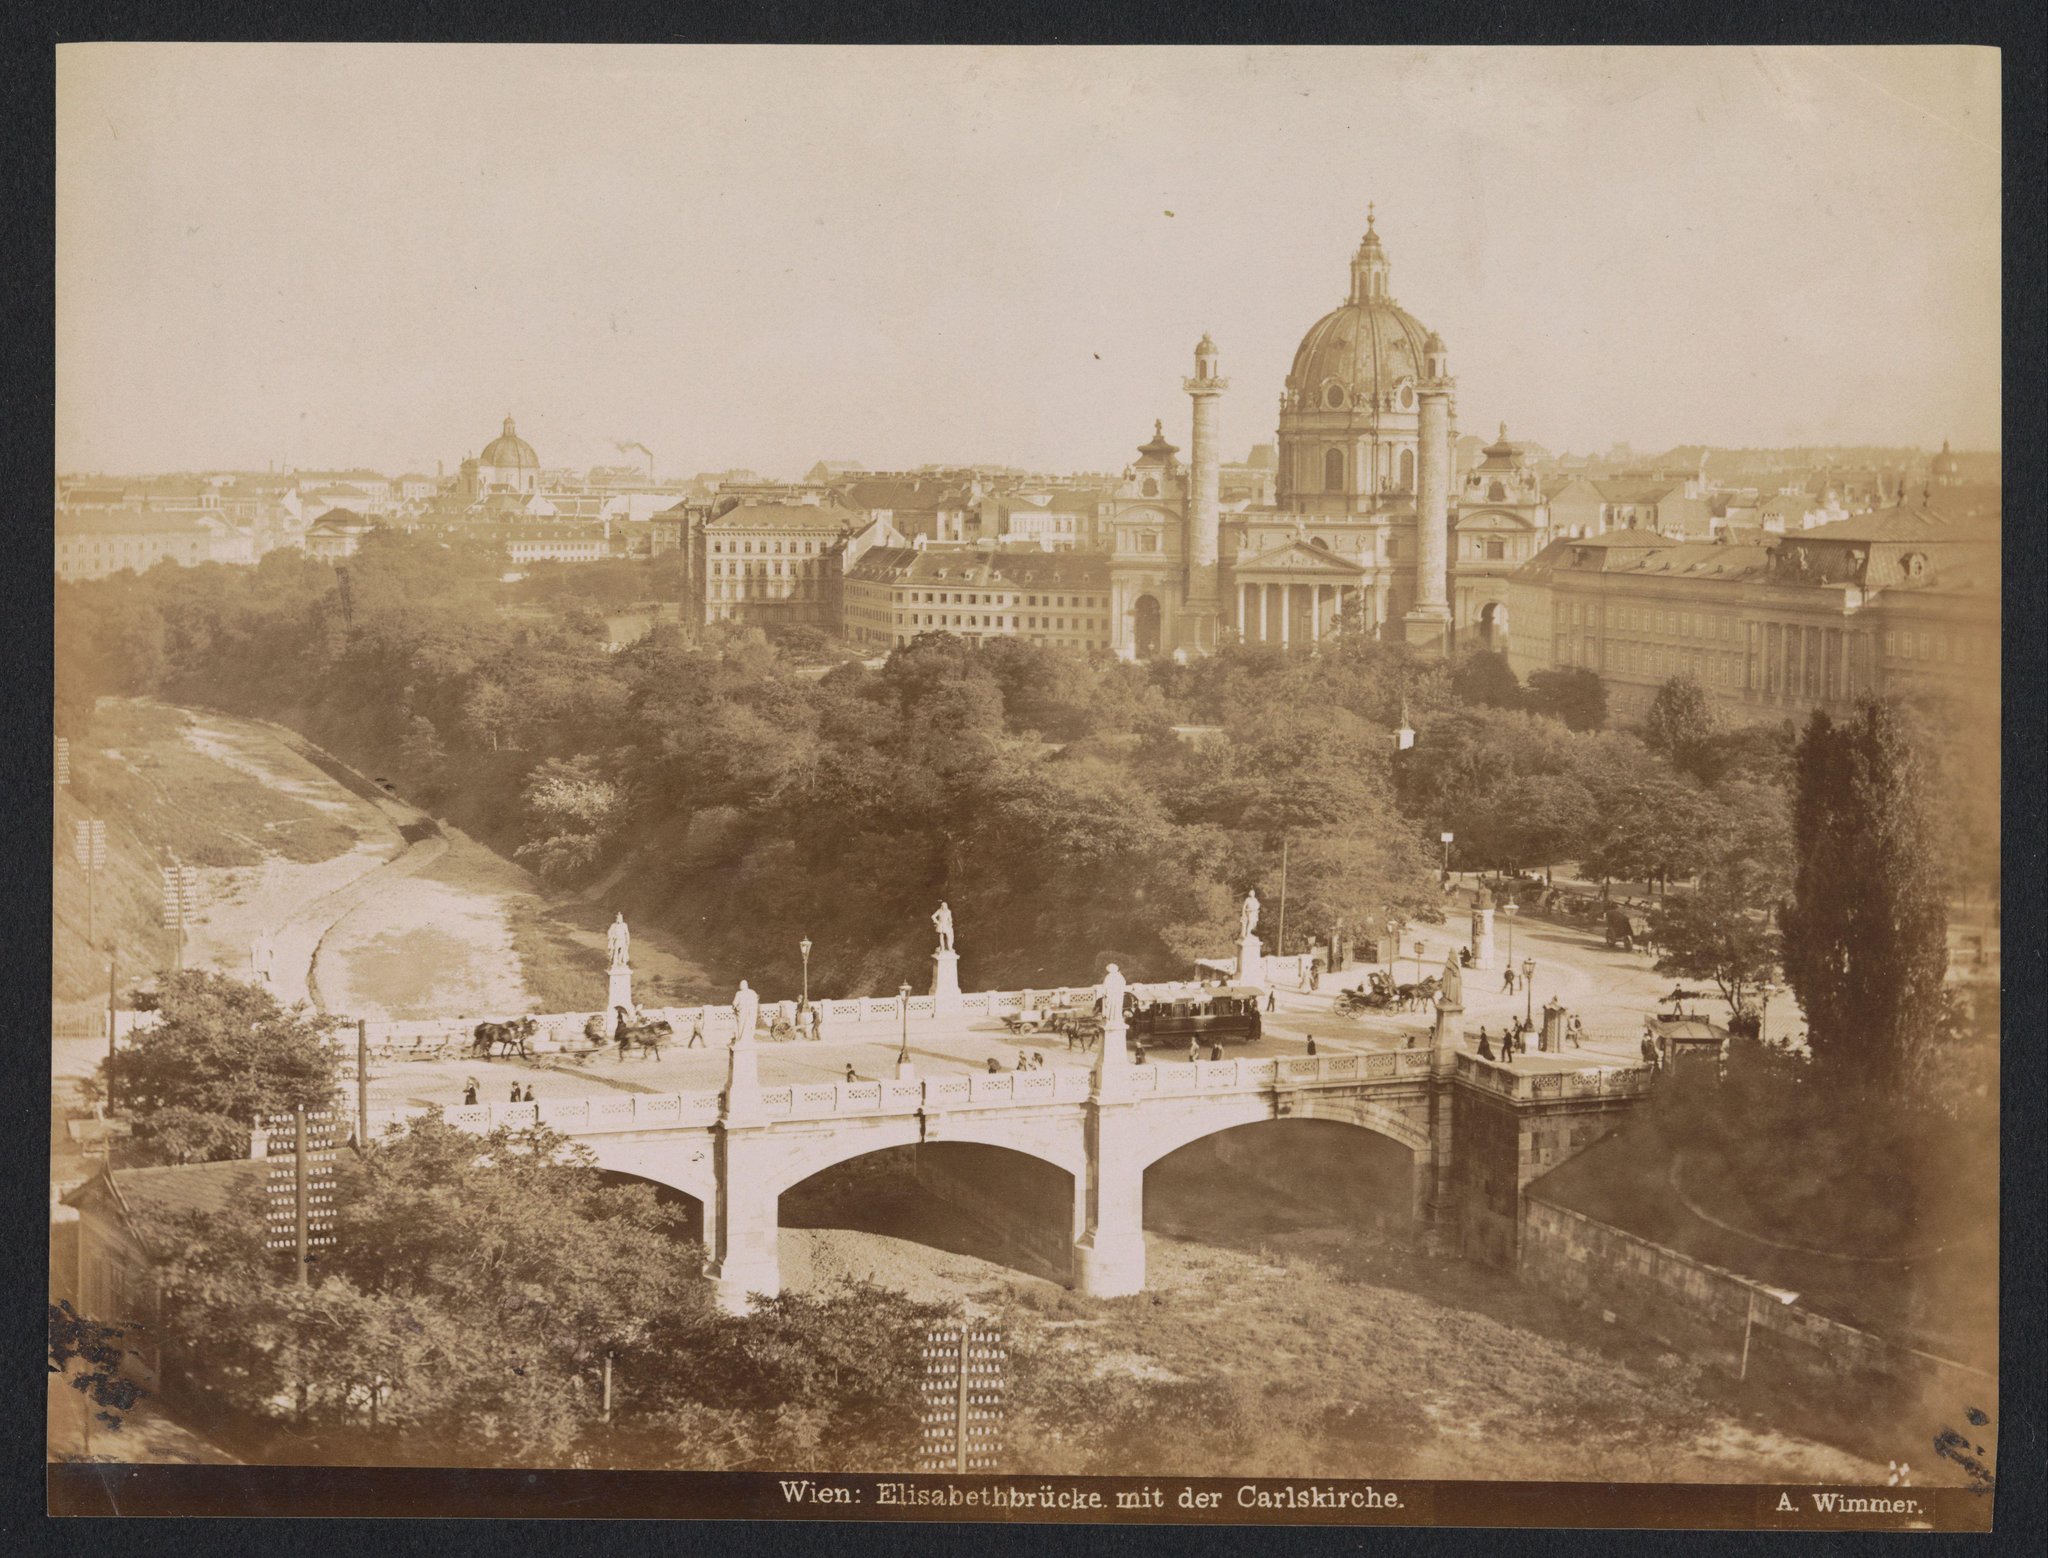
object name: photograph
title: Elisabethbrücke mit der Carlskirche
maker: a. wimmer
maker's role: fotograaf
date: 1854-1900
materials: paper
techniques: albumen print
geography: vienna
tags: city-view in general; 'veduta', church (exterior), bridge in city across river, canal, etc.